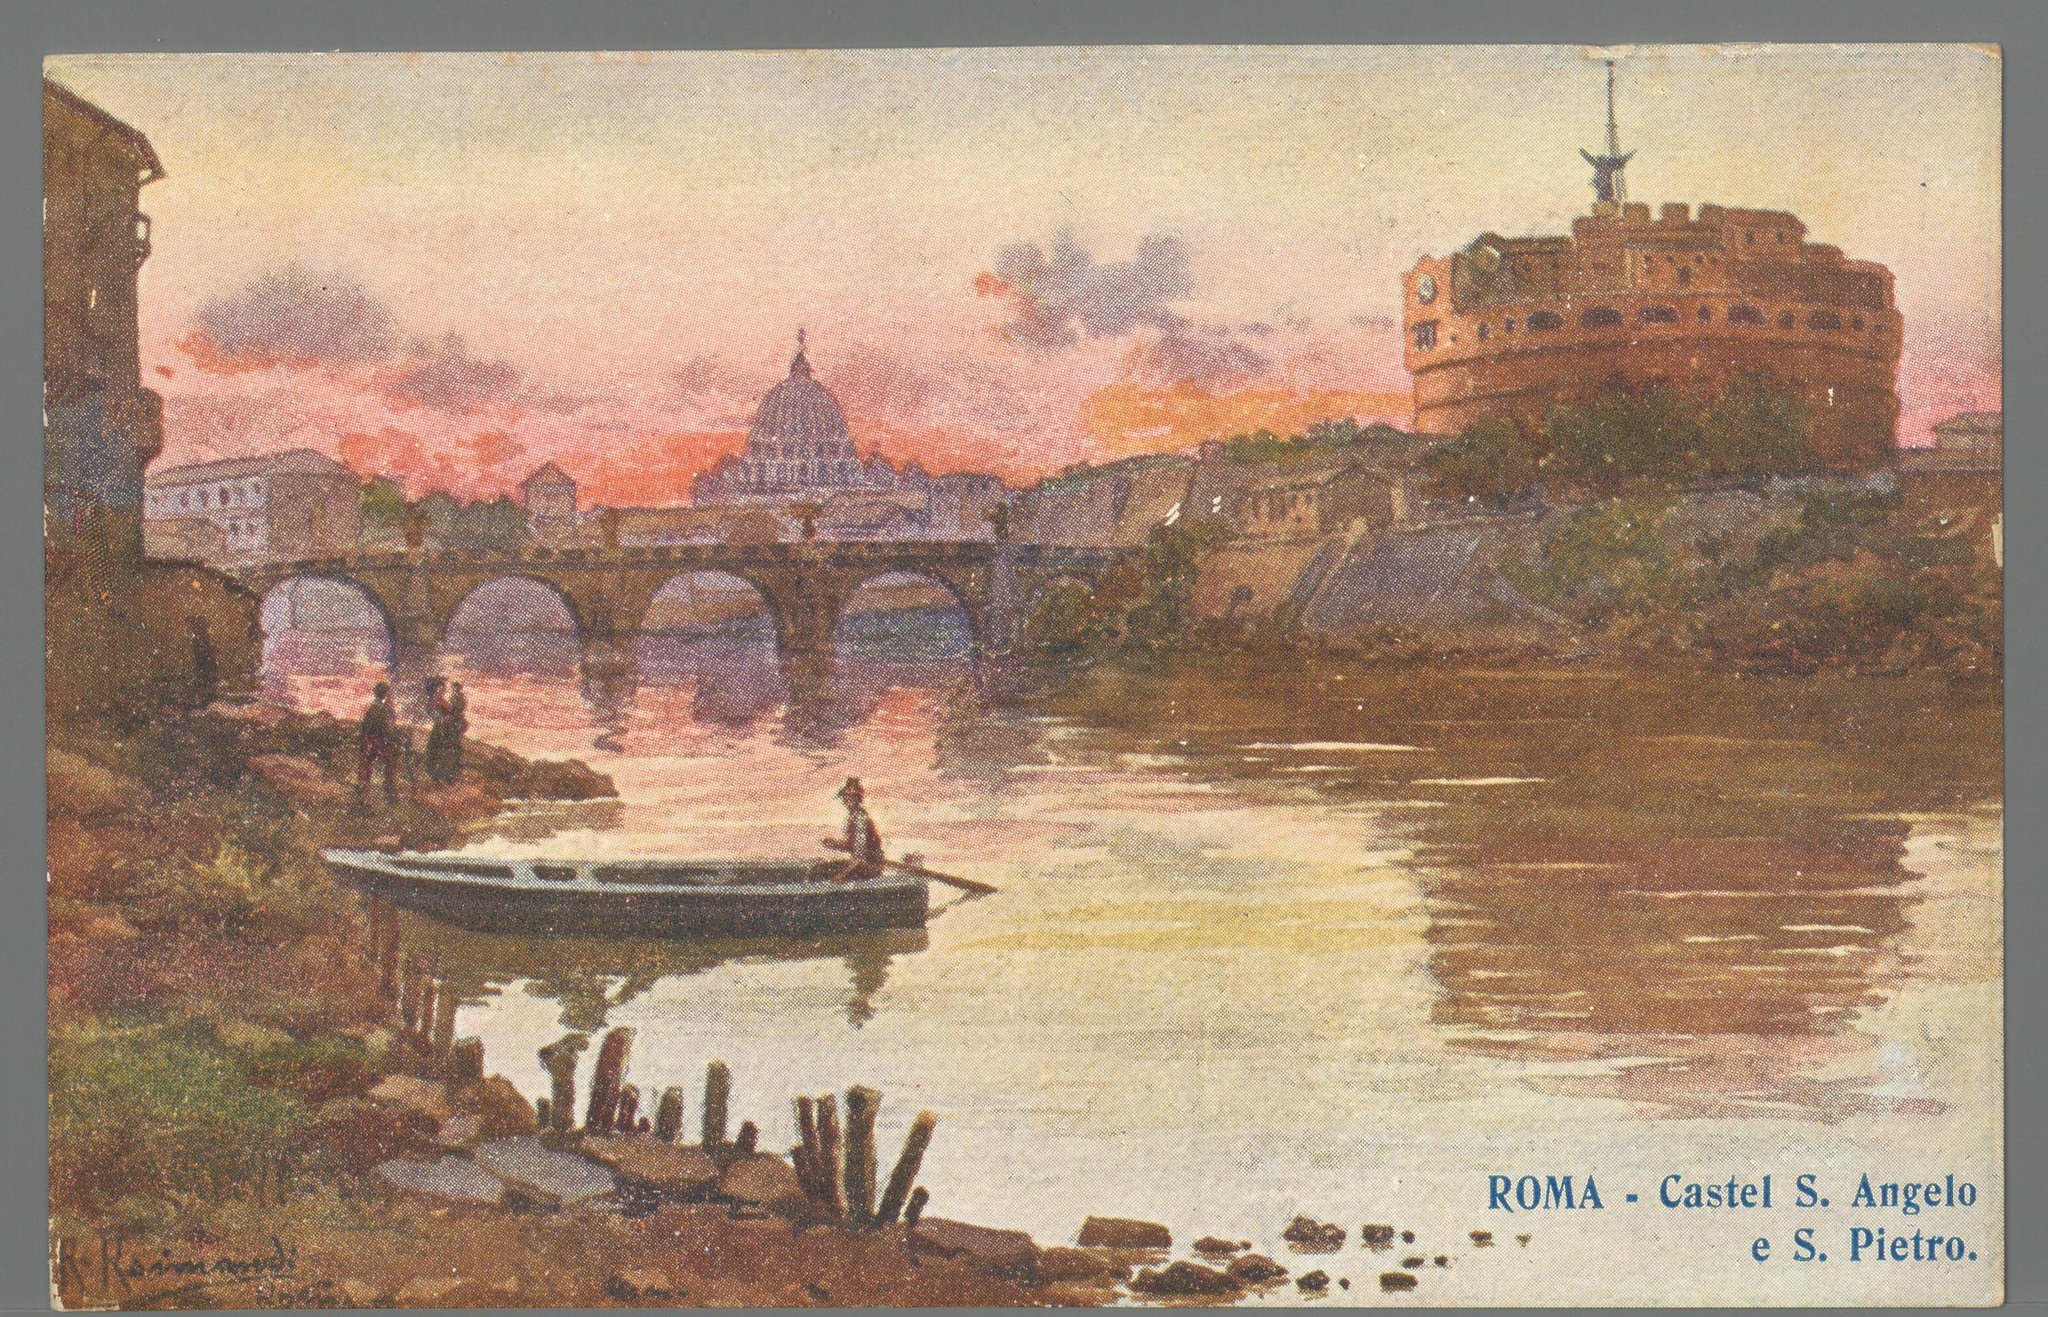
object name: ansichtkaart, prentbriefkaart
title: Roma. Castel S. Angelo e S. Pietro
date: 1906-1930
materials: cardboard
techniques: three-color autotype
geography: rome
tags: fortress, river, city-view, and landscape with man-made constructions (+ city(-scape) with figures, staffage)